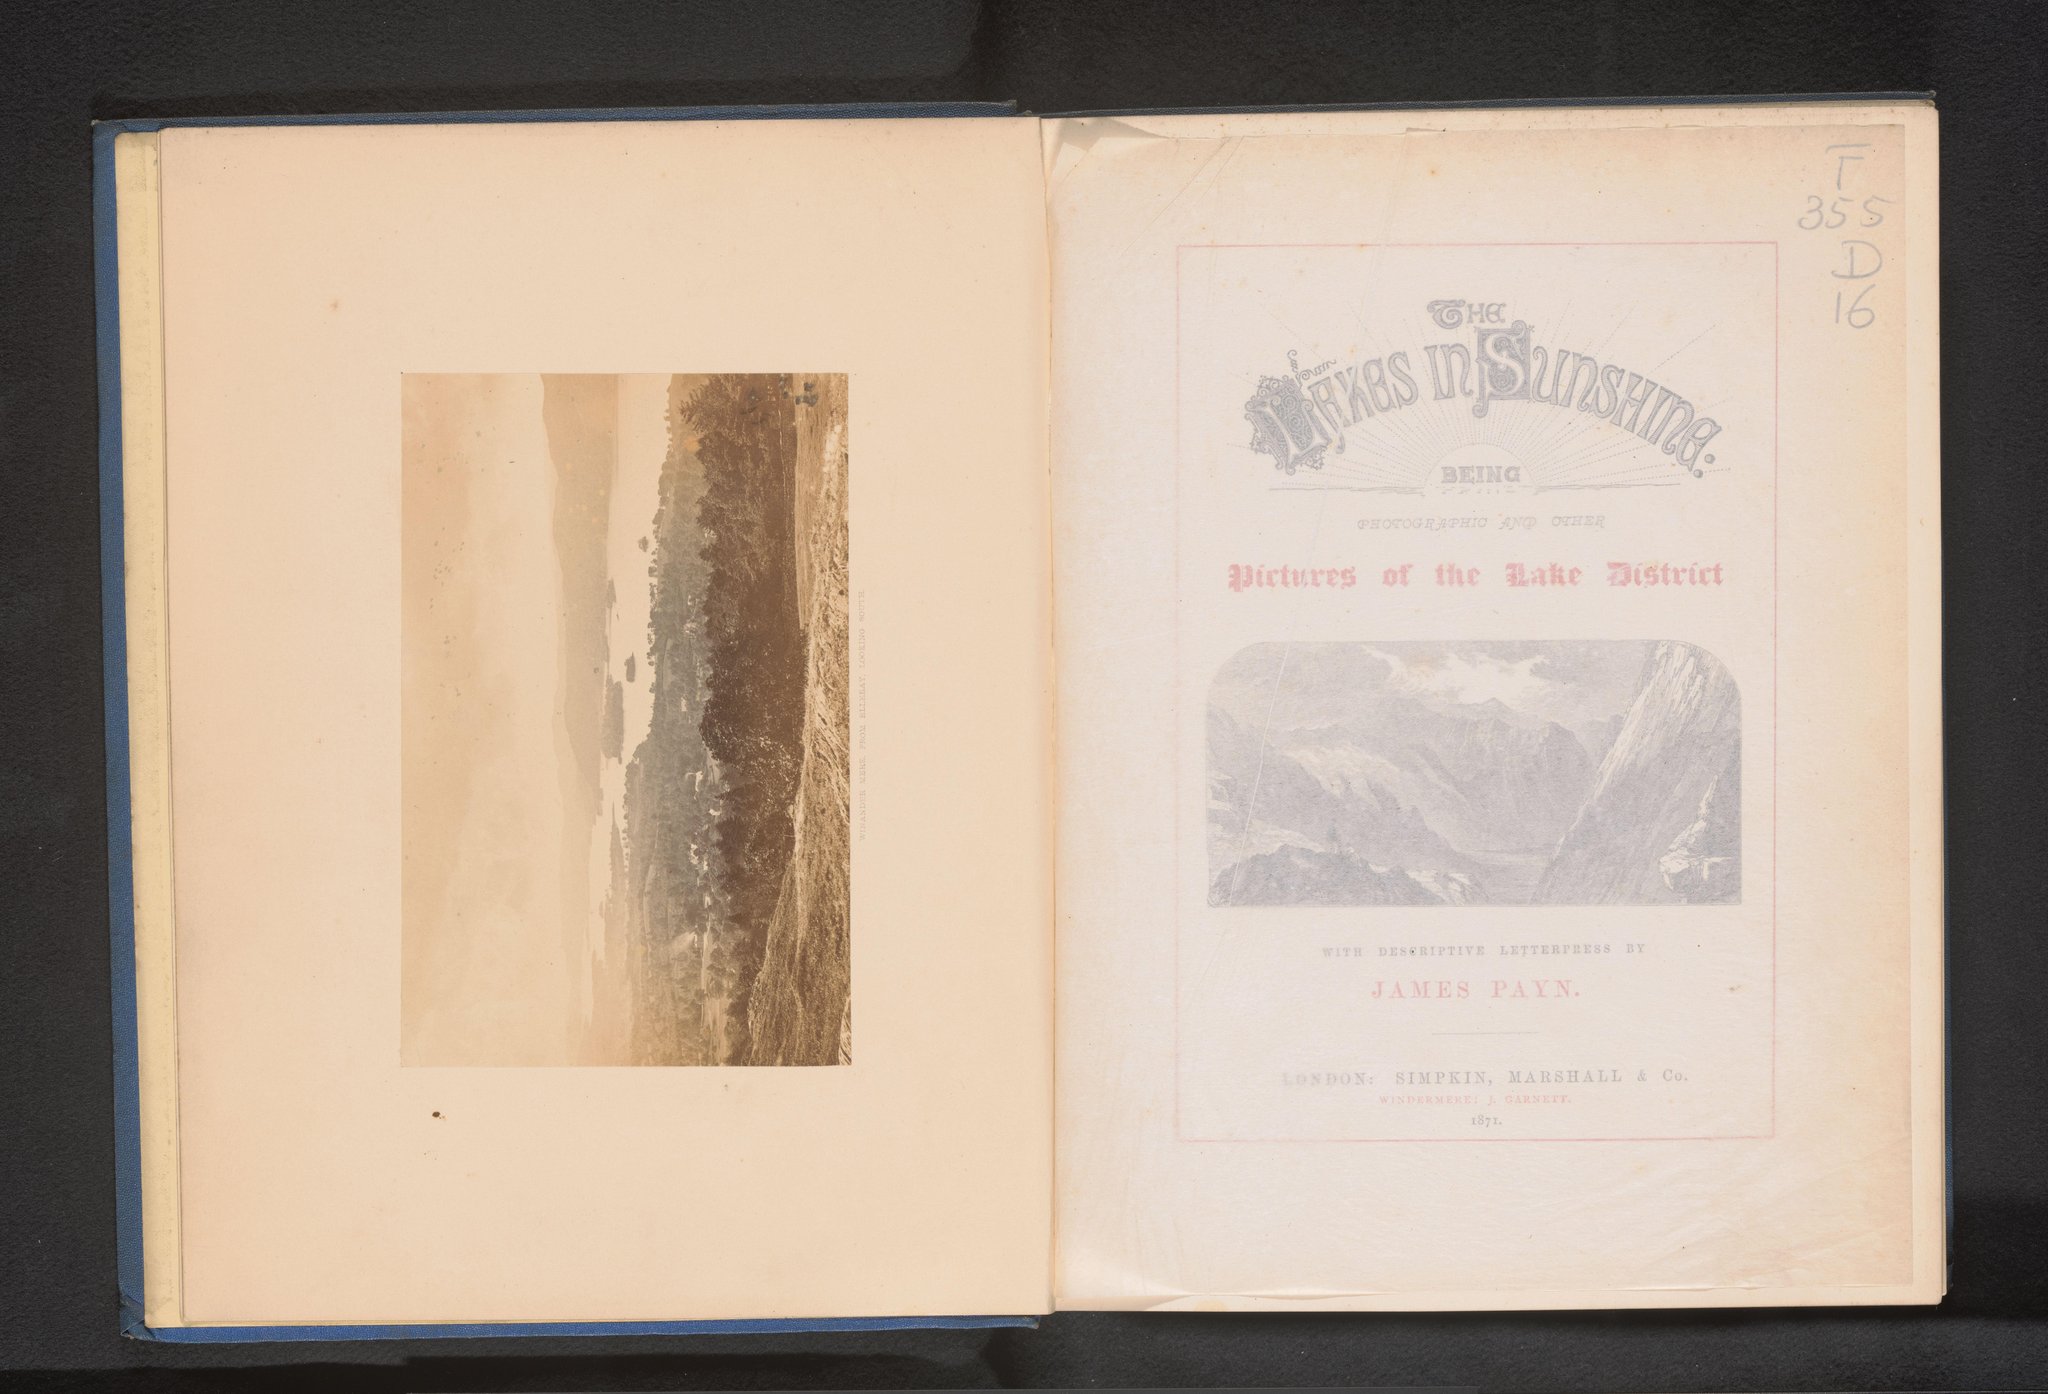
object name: photograph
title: Gezicht over het Windermere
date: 1857-1871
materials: photographic support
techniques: albumen print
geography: lake district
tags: lake